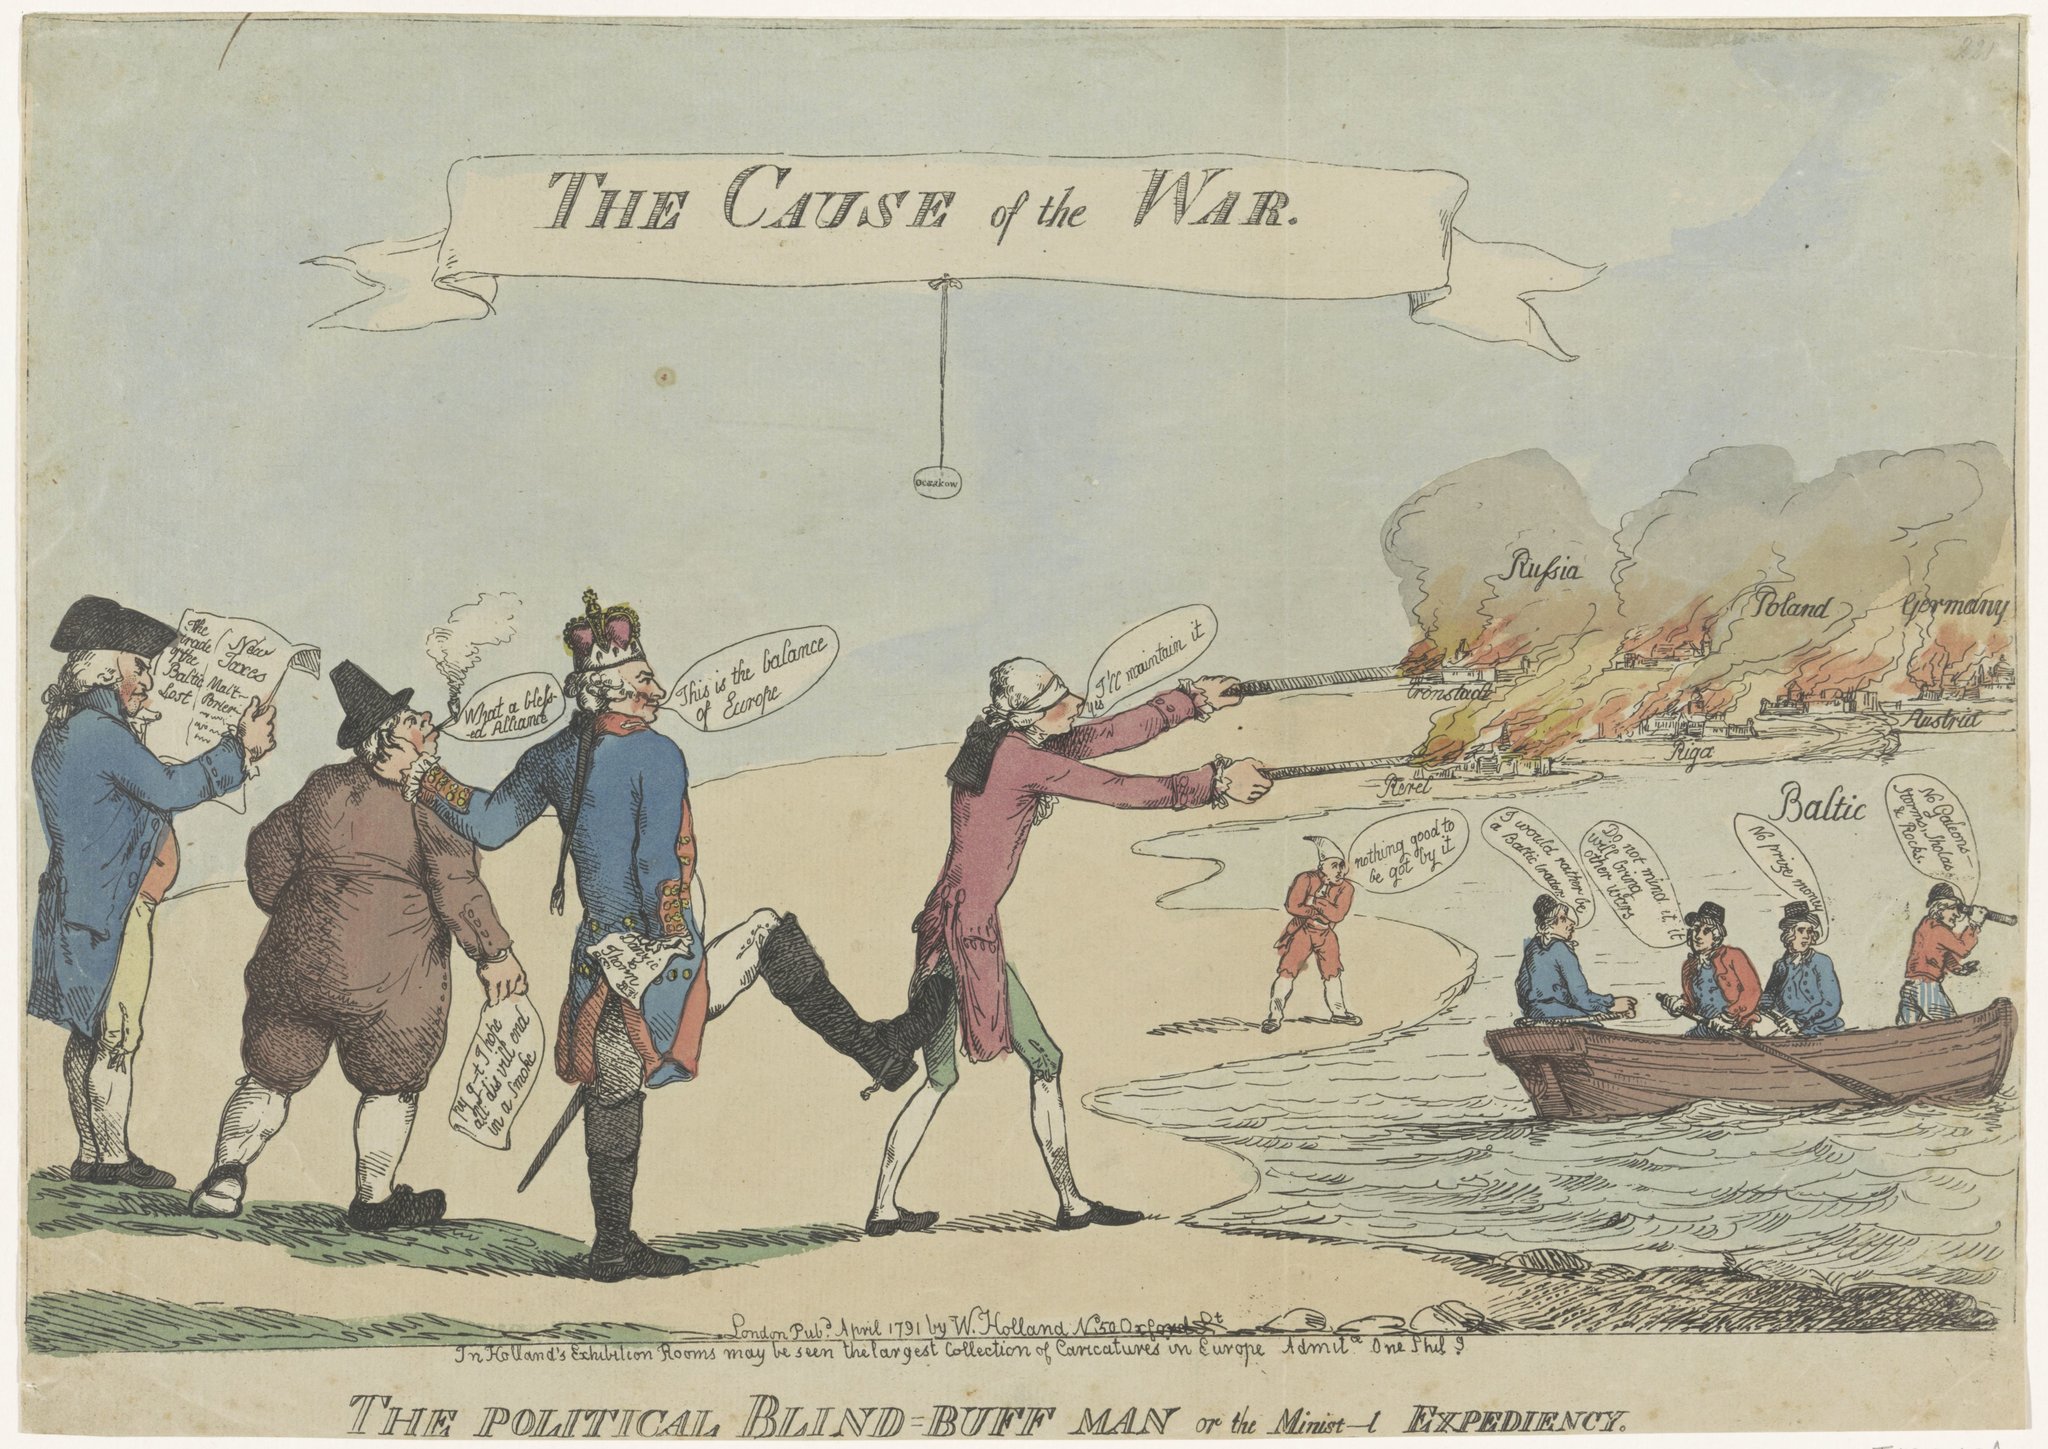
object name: cartoon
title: Spotprent op William Pitt, 1791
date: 1704-1791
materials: paper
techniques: etching, hand coloring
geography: london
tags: berlin, frederik willem ii (koning van pruisen), london, blind-man's buff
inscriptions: collector's mark: Lugt 2228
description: Spotprent op de Engelse Ruslandpolitiek, 1791. Een geblinddoekte William Pitt schiet met twee pistolen op brandende steden en landen in Oost-Europa. De Pruisische koning Frederik Willem II schopt Pitt op zijn achterste en houdt de Hollander vast aan zijn oor. Spotprent op de Engelsen die zich door Pruisen inzake politiek in Oost-Europa en Danzig voor hun karretje laten spannen.